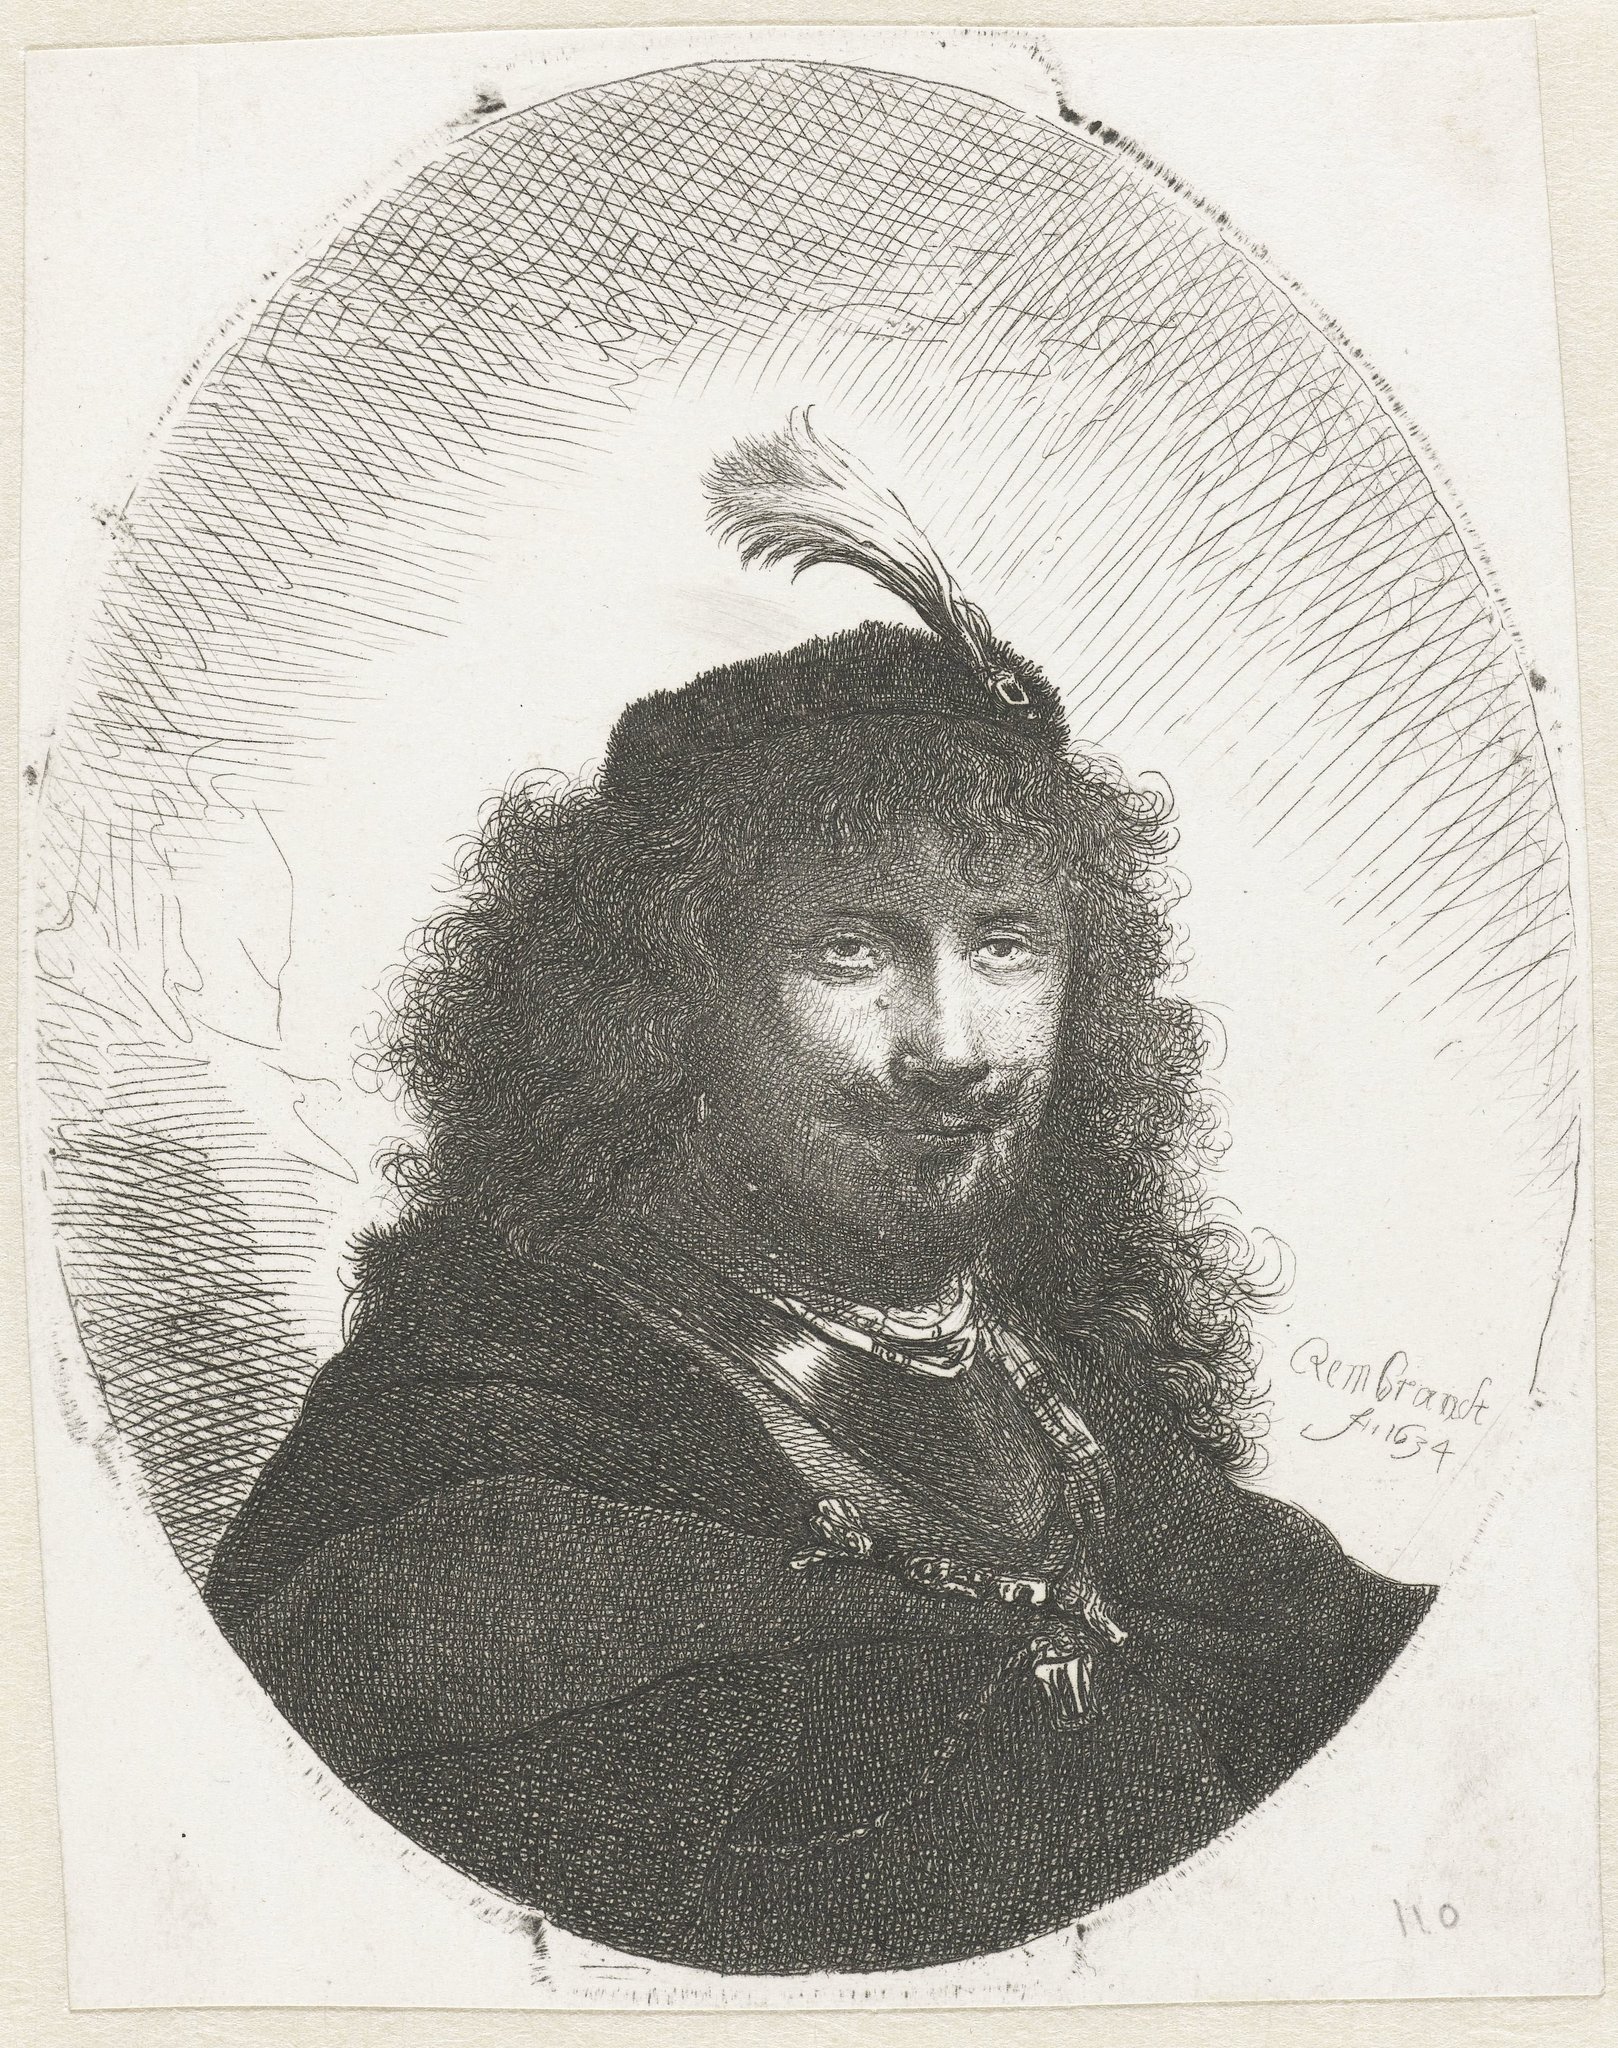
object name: print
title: Self-portrait (?) with plumed cap and lowered sabre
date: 1805-1844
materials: paper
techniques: etching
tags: leiden, amsterdam, painter, draughtsman, rembrandt van rijn, portrait, self-portrait of graphic artist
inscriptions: collector's mark: Lugt 2228, collector's mark: Lugt 2760